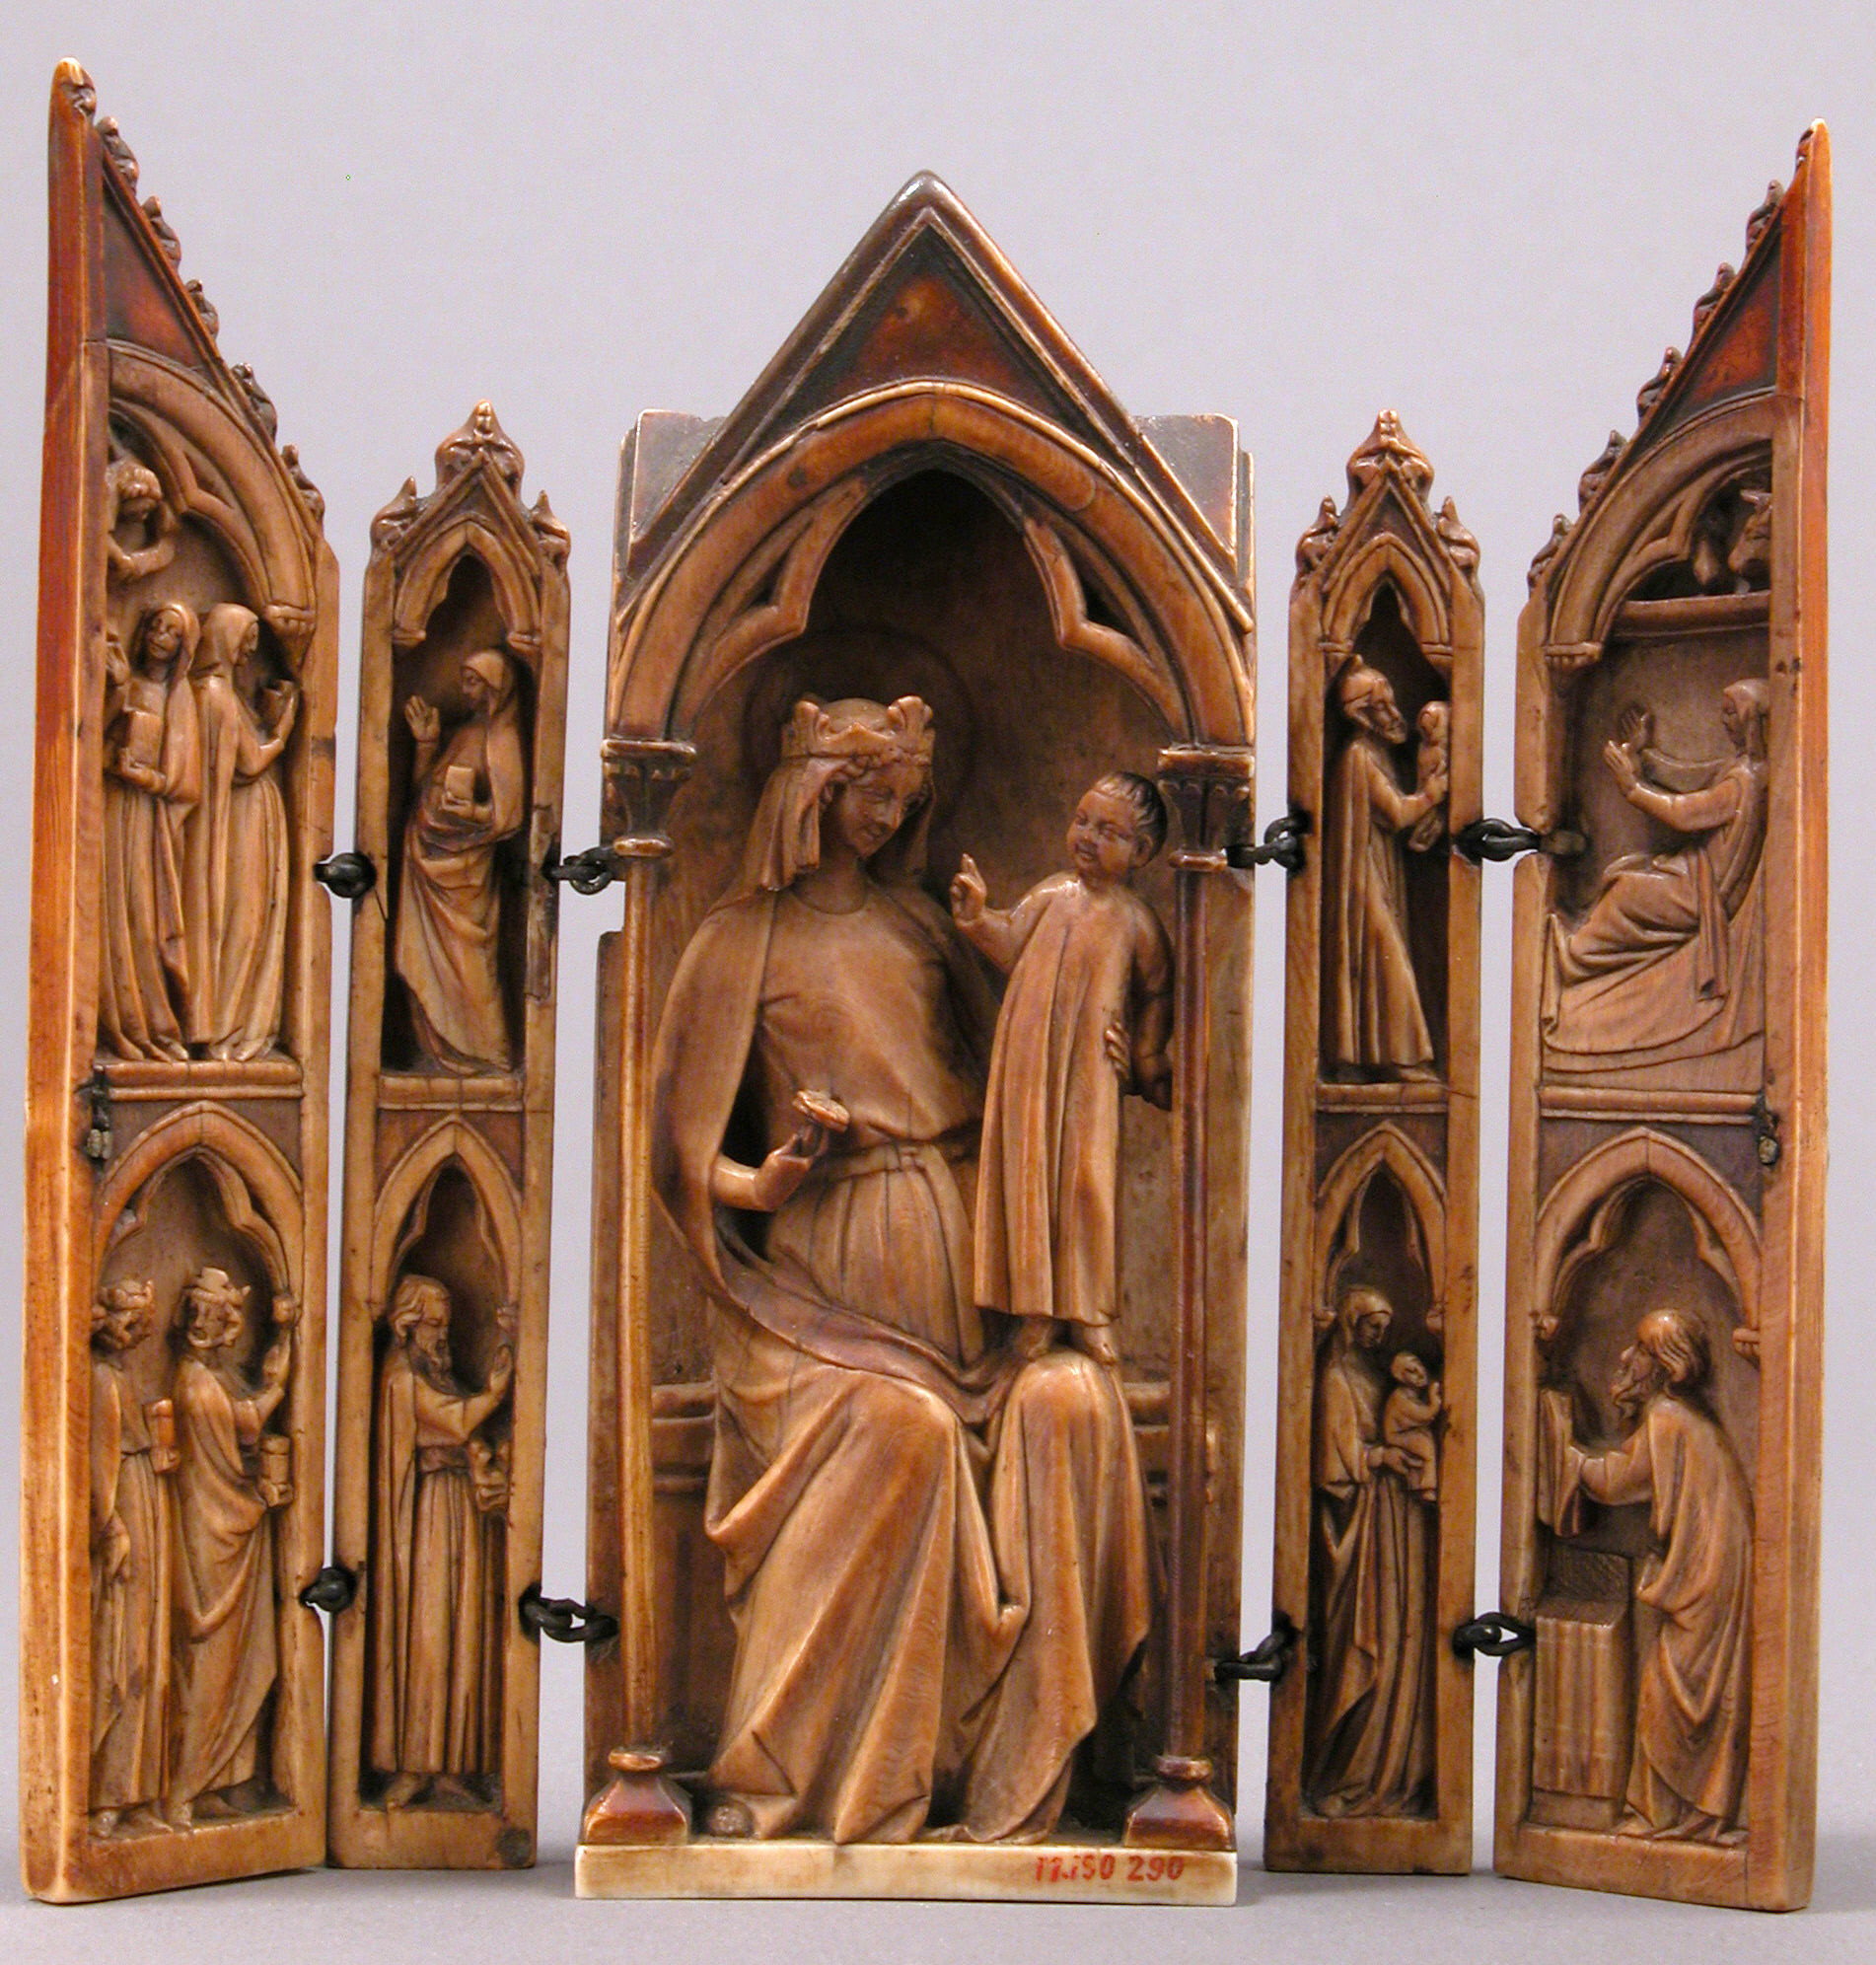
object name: folding shrine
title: Folding Shrine with Virgin and Child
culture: french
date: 1325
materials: ivory, metal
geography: france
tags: christ,virgin mary